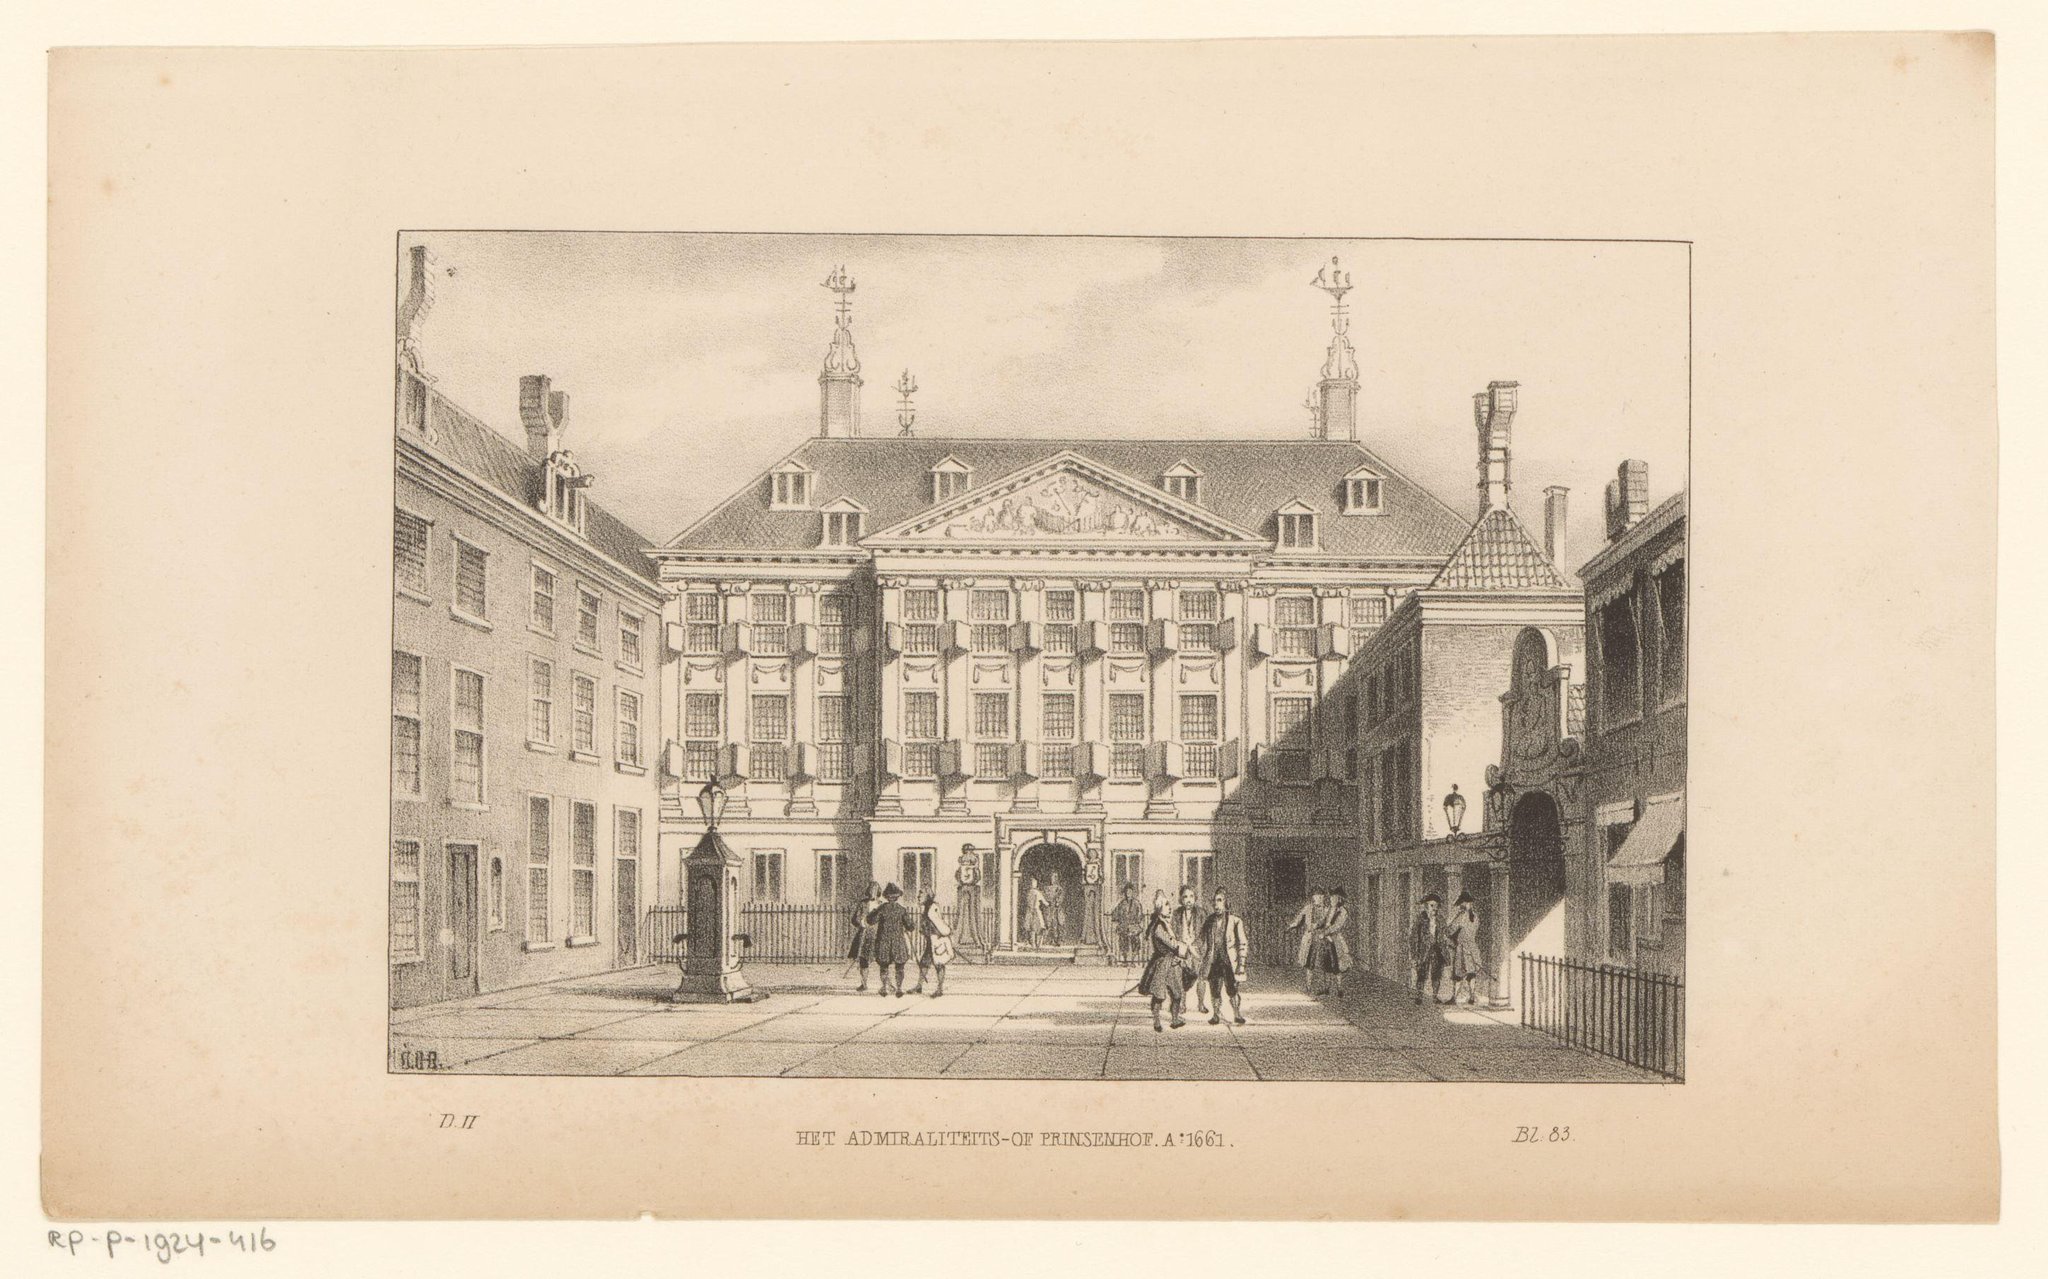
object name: print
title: Het admiraliteits- of prinsenhof Ao 1661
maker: johannes hilverdink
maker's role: draughtsman, painter, print maker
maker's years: 1813-1902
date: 1844-1848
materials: paper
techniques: lithograph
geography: amsterdam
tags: courtyard, inner court of palace or 'hôtel', amsterdam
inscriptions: collector's mark: Lugt 2233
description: De binnenplaats van het Admiraliteits- of Prinsenhof was gelegen aan de Oudezijds Voorburgwal. Op het plein lopen figuren. Rechts de hoofdingang. Genummerd linksonder: D II en rechtsonder: Bl. 83.